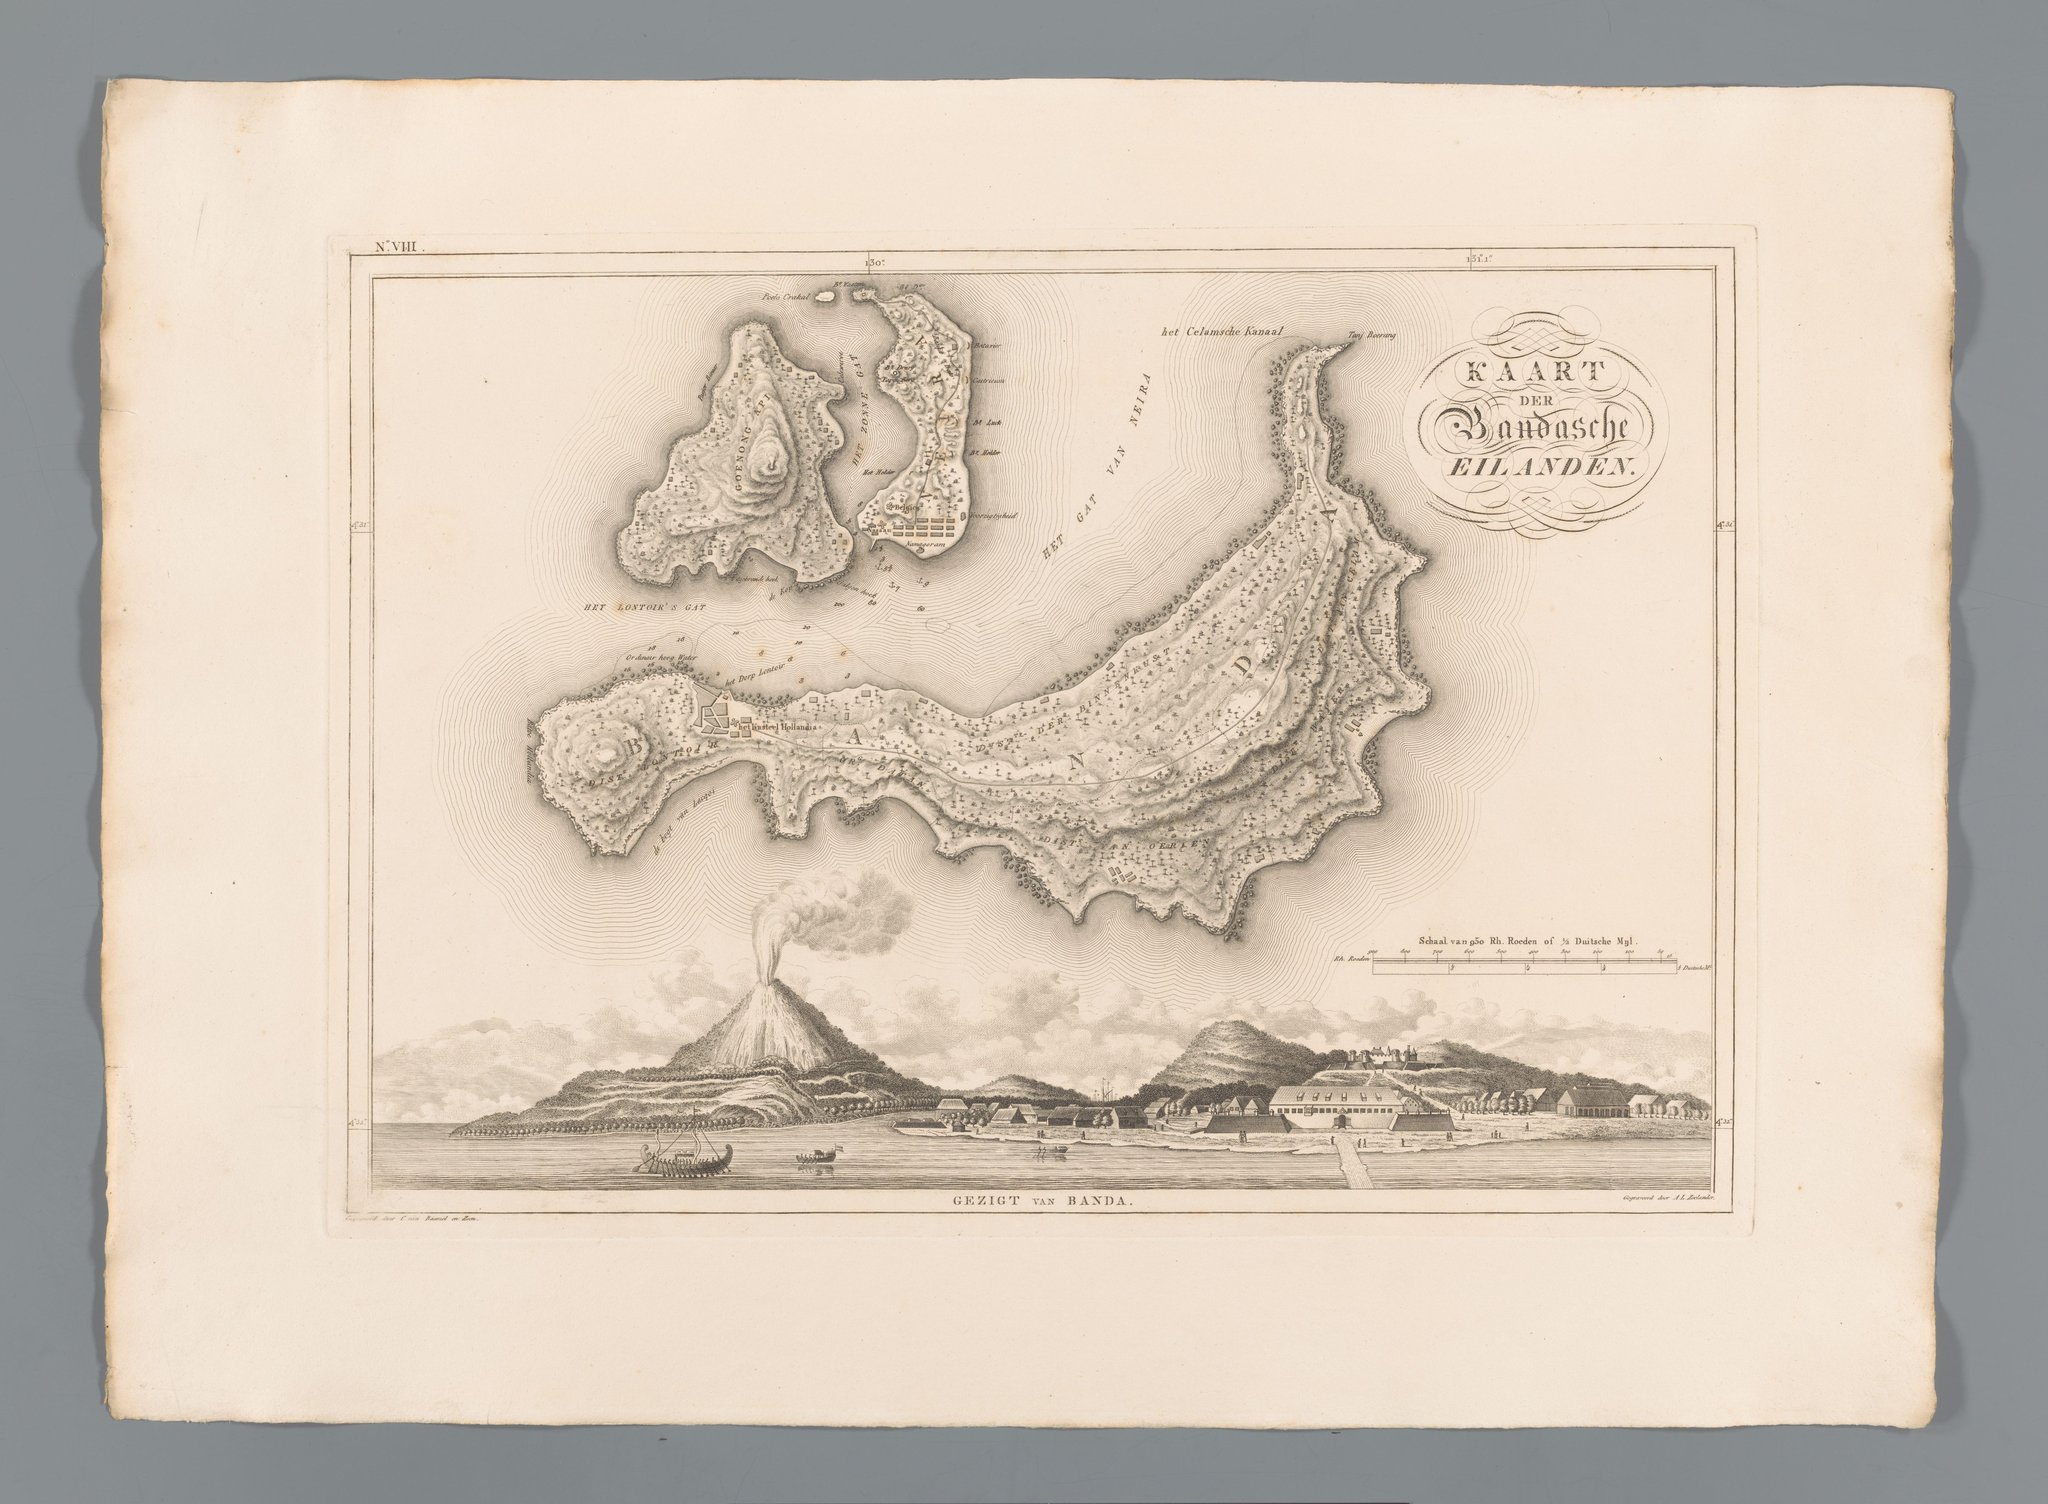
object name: map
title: Gezigt van Banda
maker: abraham lion zeelander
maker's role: draughtsman, print maker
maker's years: 1789-1856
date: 1818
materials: paper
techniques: engraving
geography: the hague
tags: maps of separate countries or regions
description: Kaart uit: Bosch, Js. van den. Atlas der overzeesche bezittingen van Zijne Majesteit den Koning der Nederlanden, aan hoogst denzelven opgedragen. Den Haag en Amsterdam: Gebroeders van Cleef, 1818.